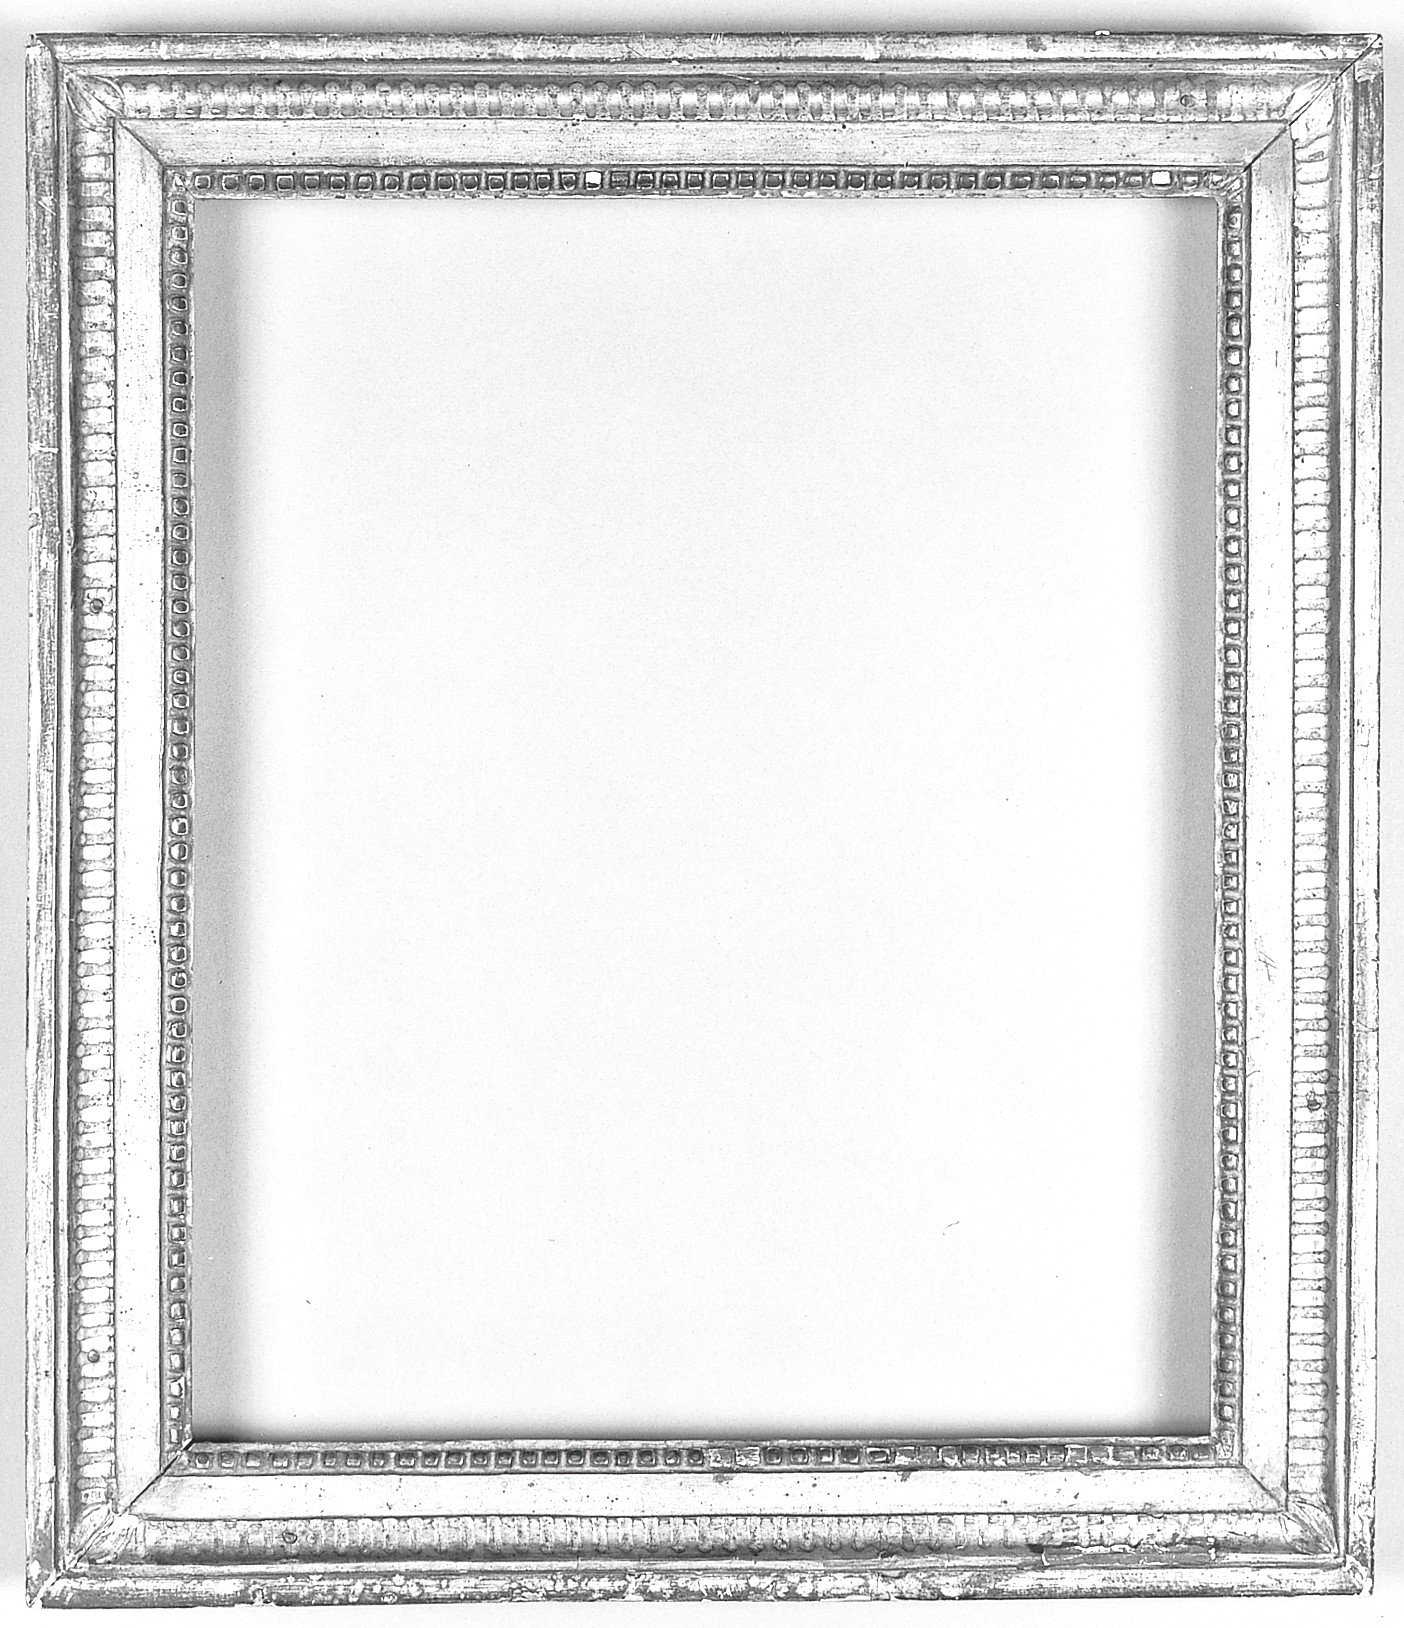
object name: frame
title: Cassetta frame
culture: french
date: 1801-1833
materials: wood